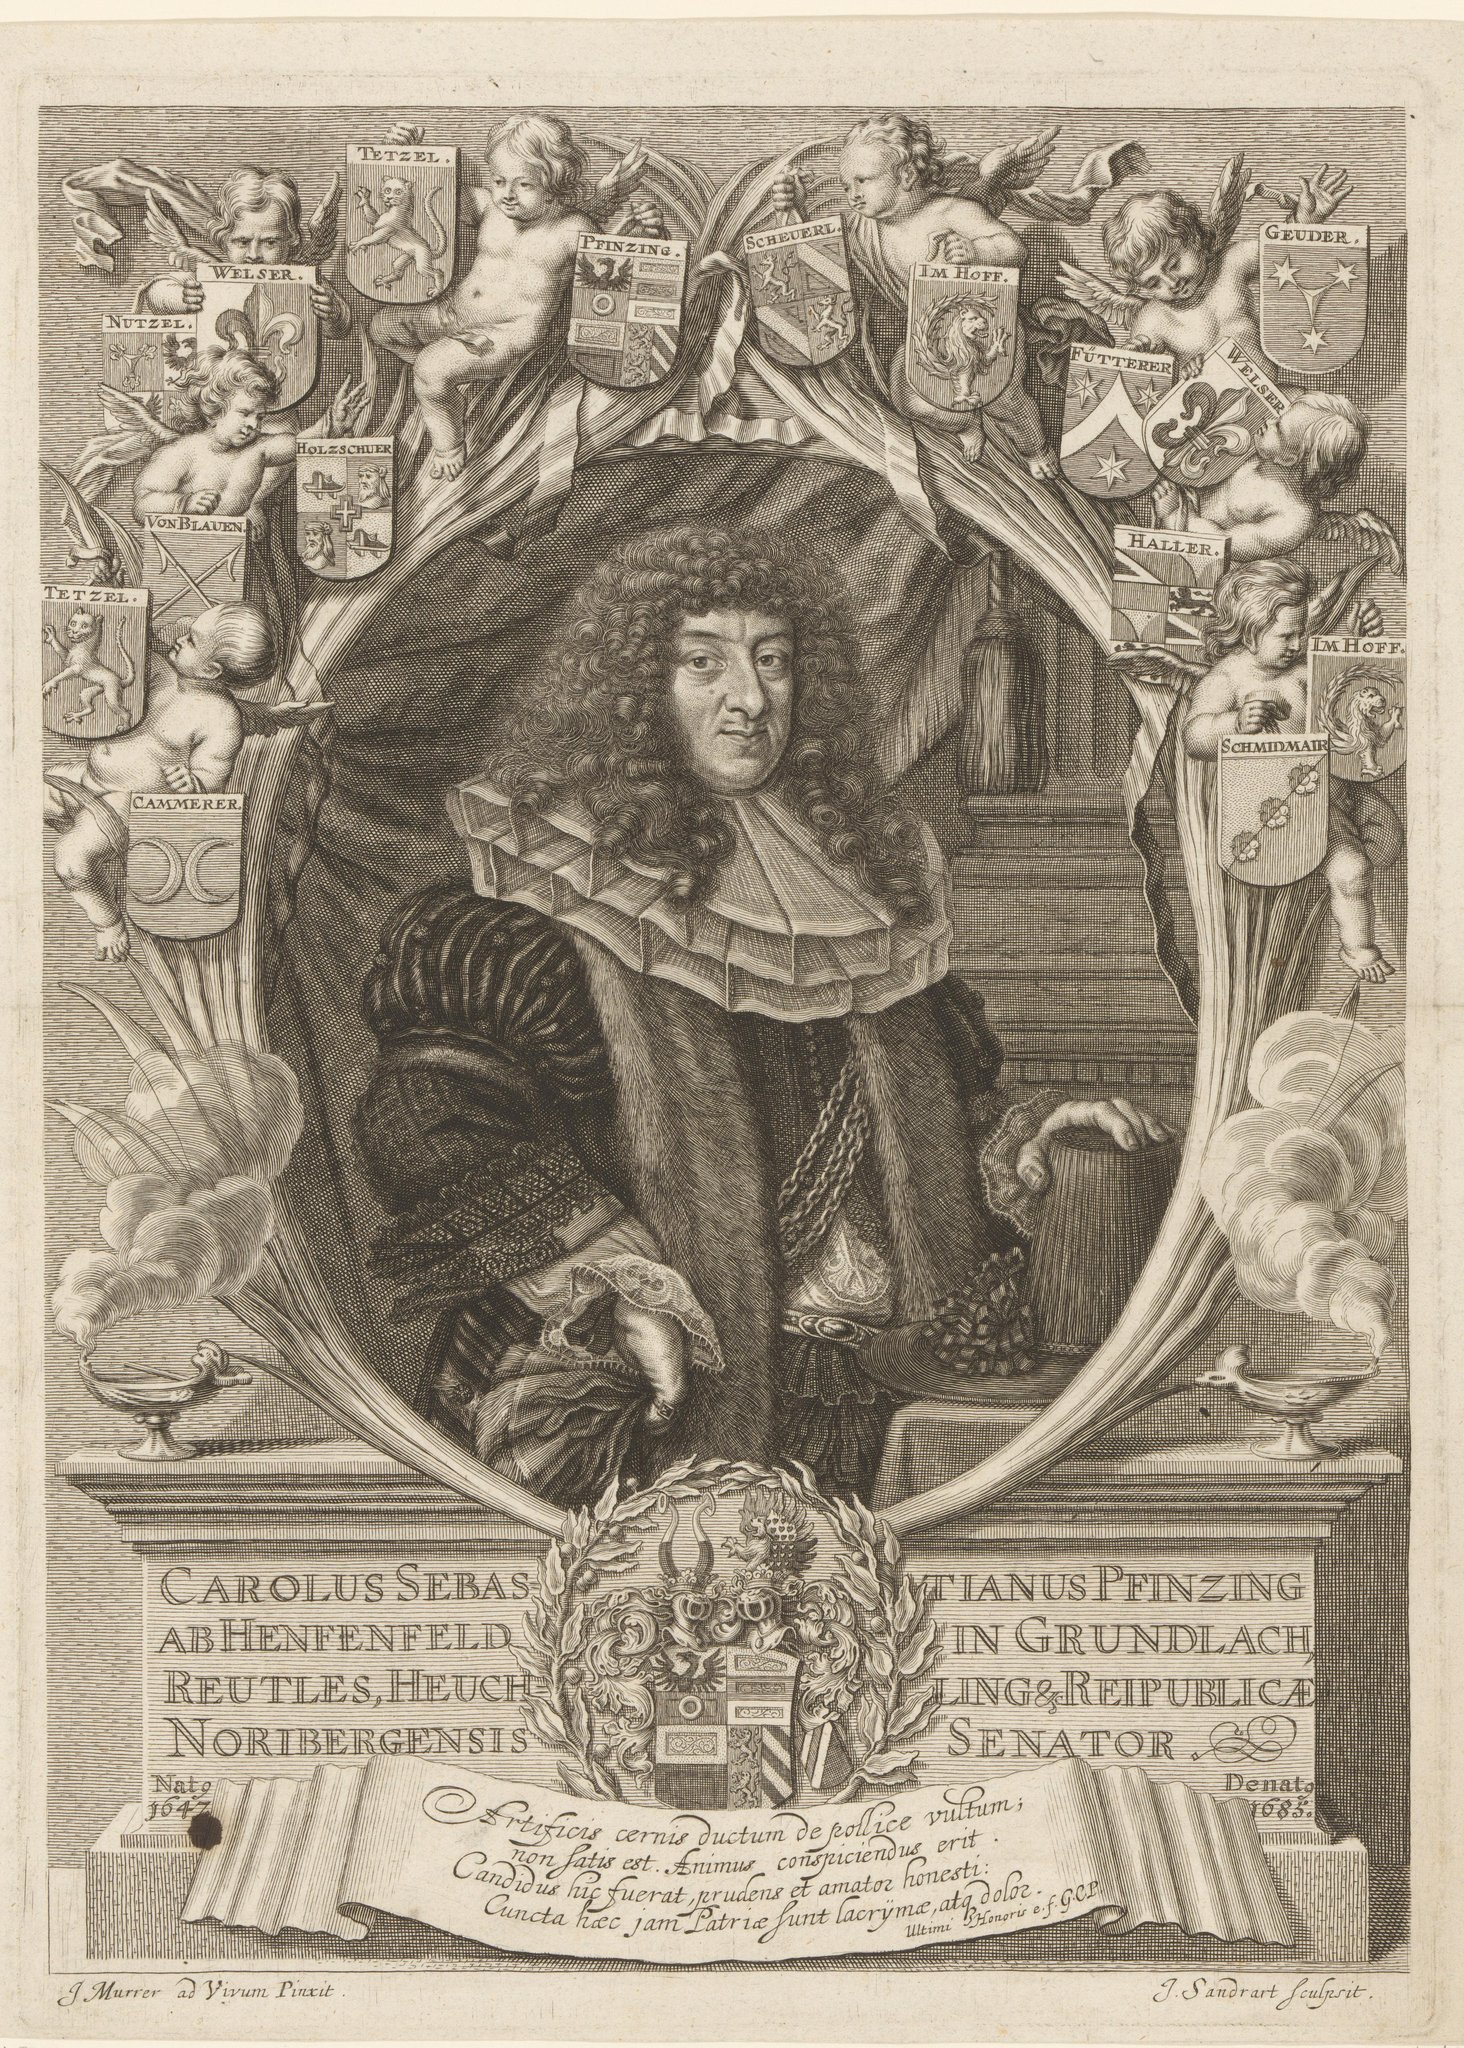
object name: print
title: Portret van Carl Sebastian Pfinzing von Henfenfeld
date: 1685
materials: paper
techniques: engraving, etching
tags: historical persons, oil-lamp, armorial bearing, heraldry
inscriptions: collector's mark: Lugt 2228